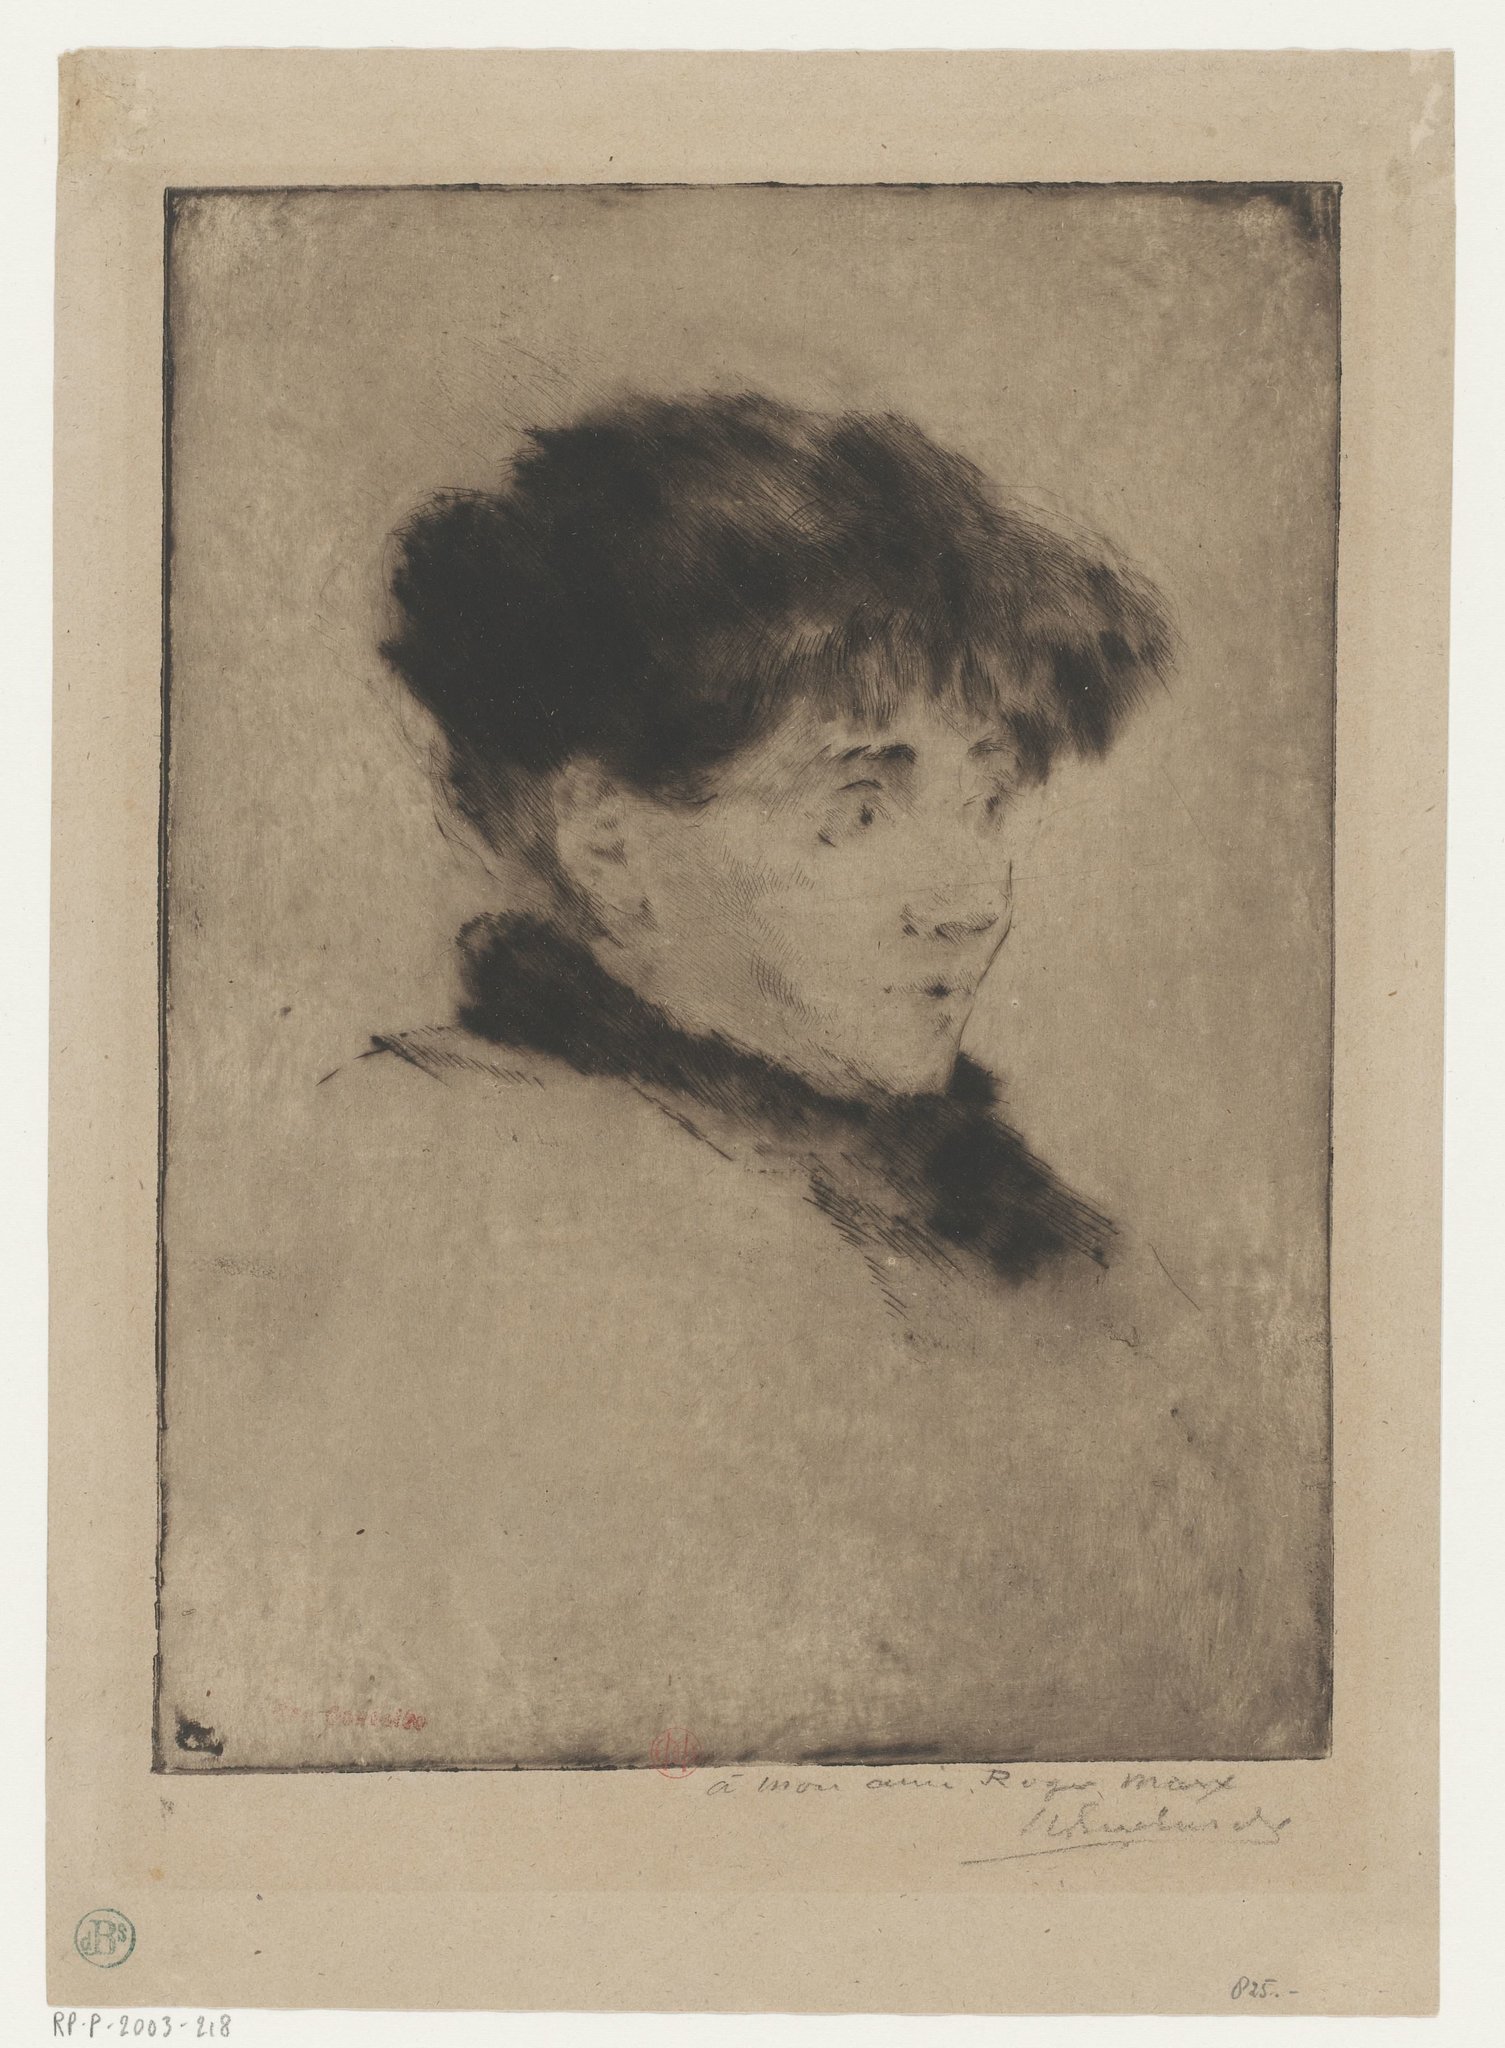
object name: print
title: Portret van Eva Gonzalès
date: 1856-1897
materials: paper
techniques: drypoint, intaglio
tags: paris, painter, eva gonzalès, historical persons, portrait, self-portrait of artist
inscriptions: dedication: ‘a mon ami, Roger Marx’, collector's mark: Lugt 733, stamp: Lugt 1157